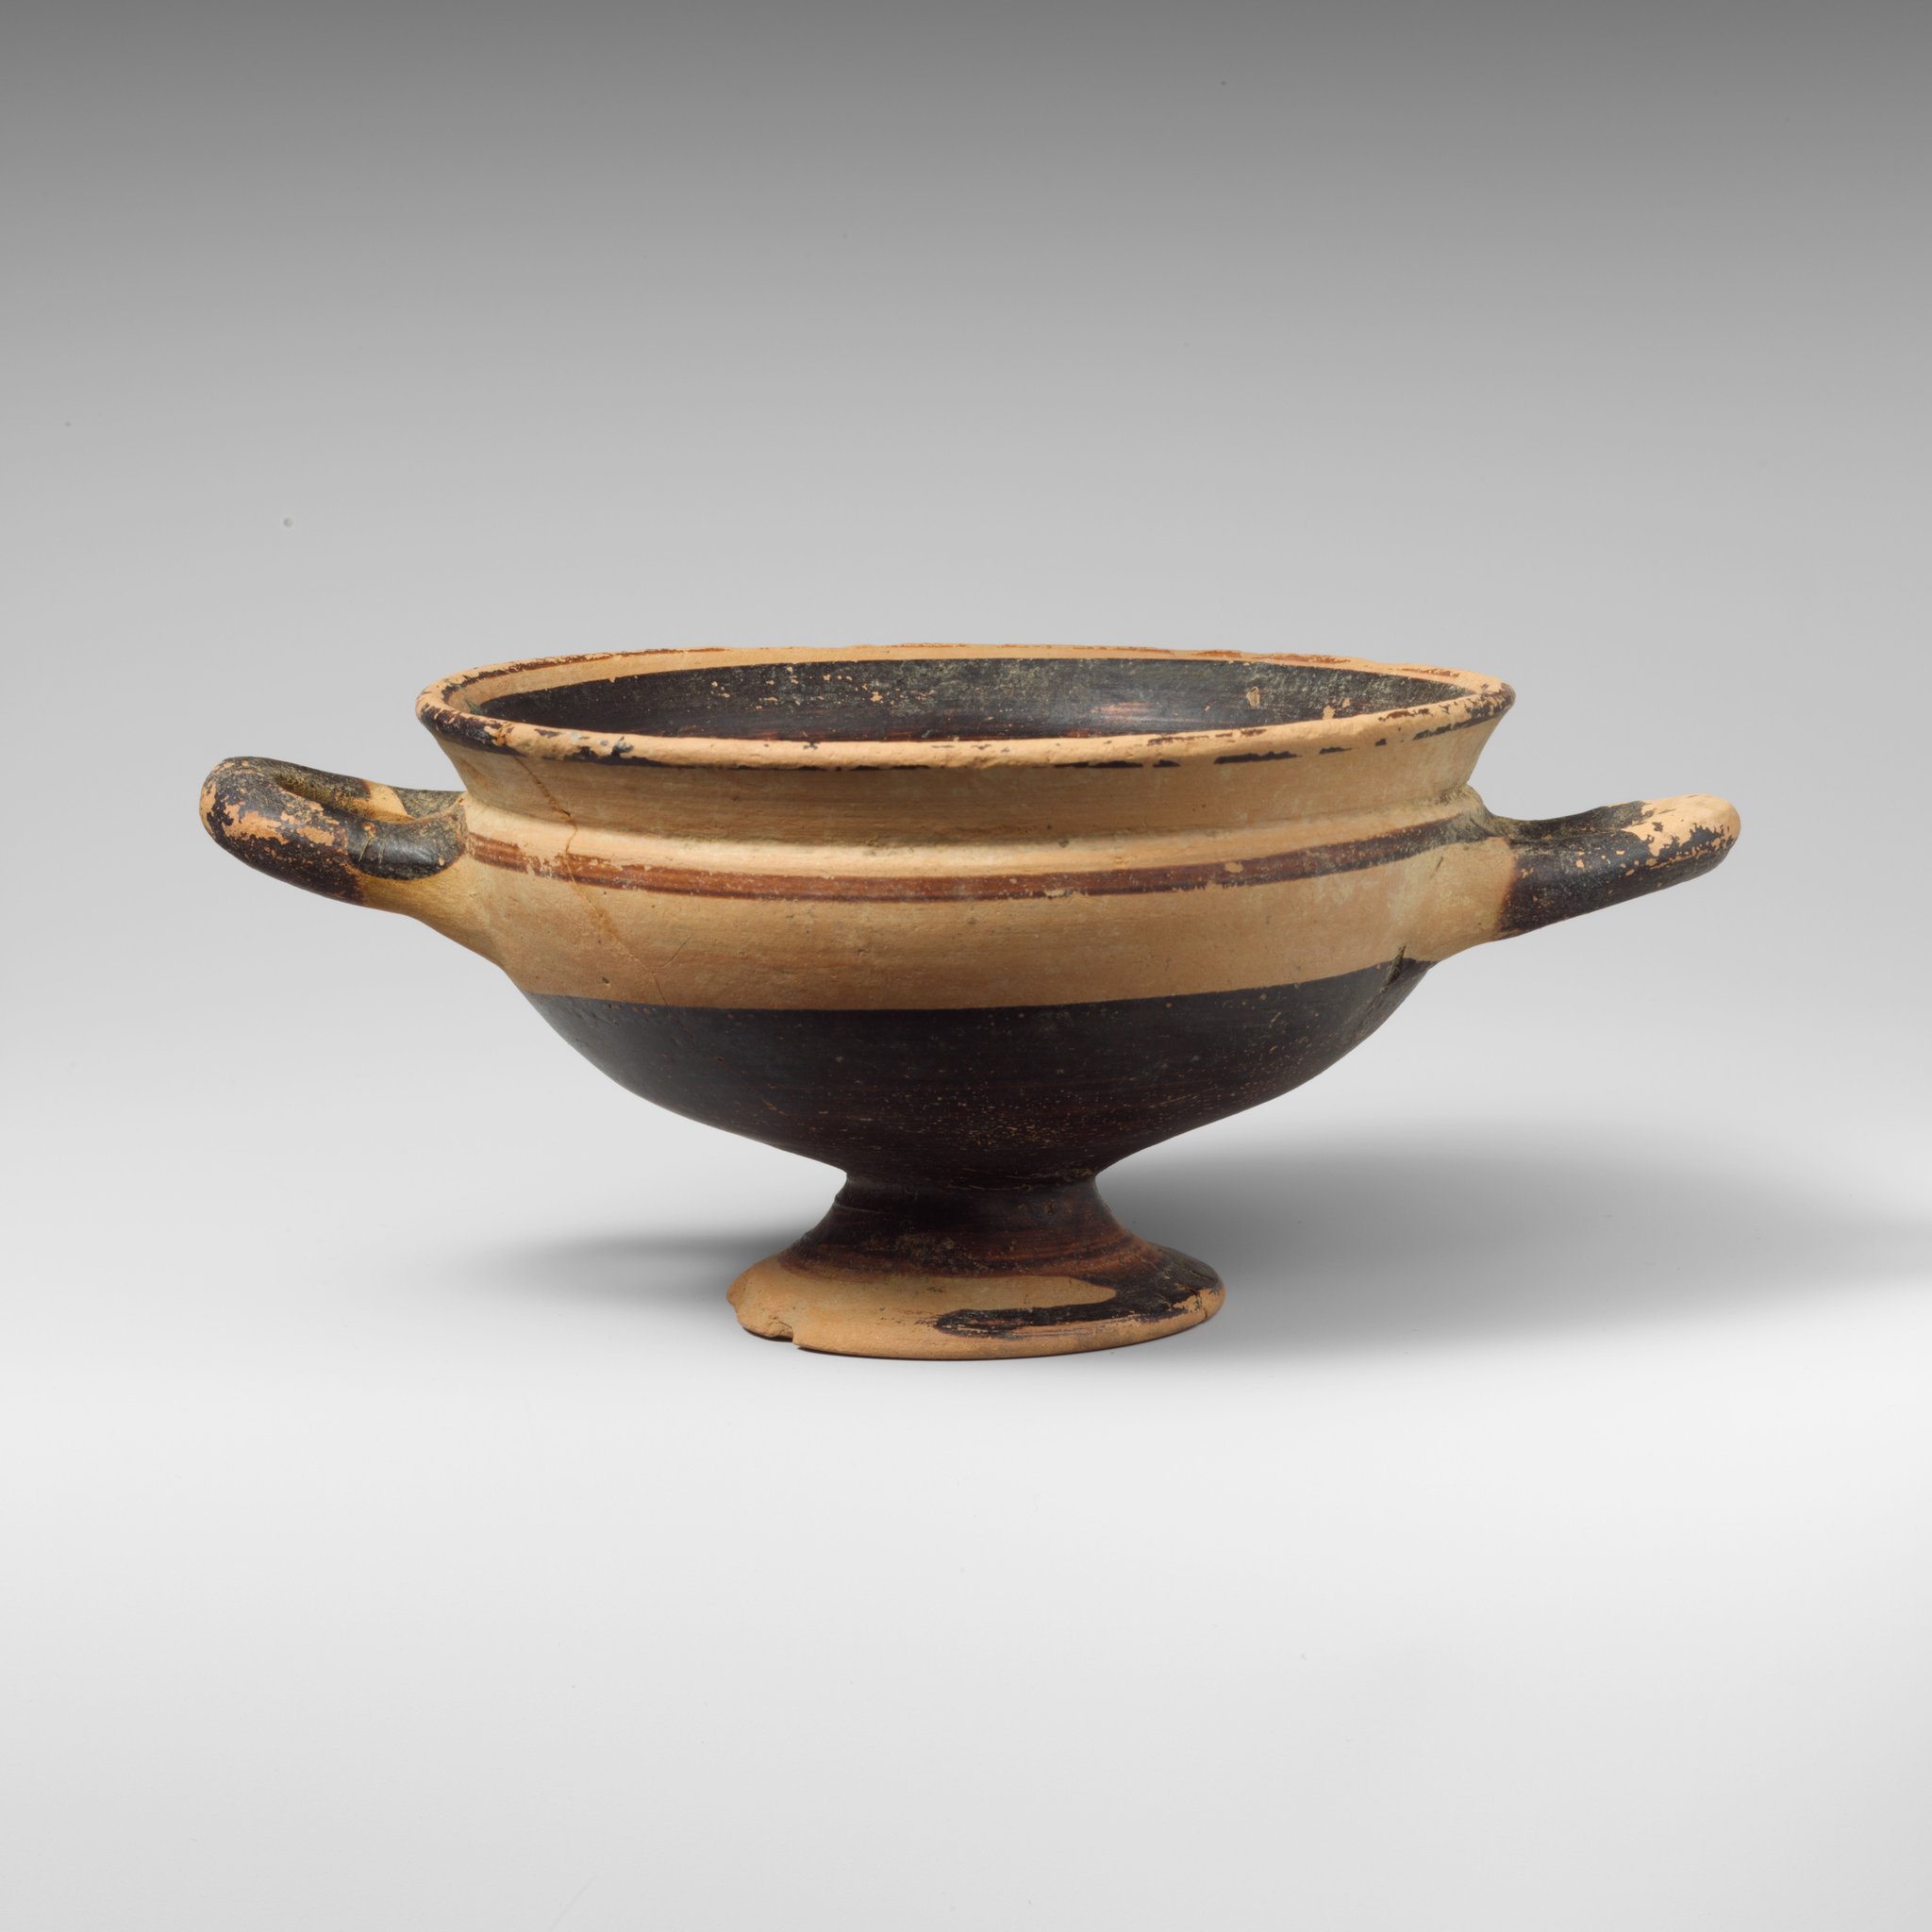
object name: kylix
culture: cypriot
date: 600-501 BCE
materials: terracotta